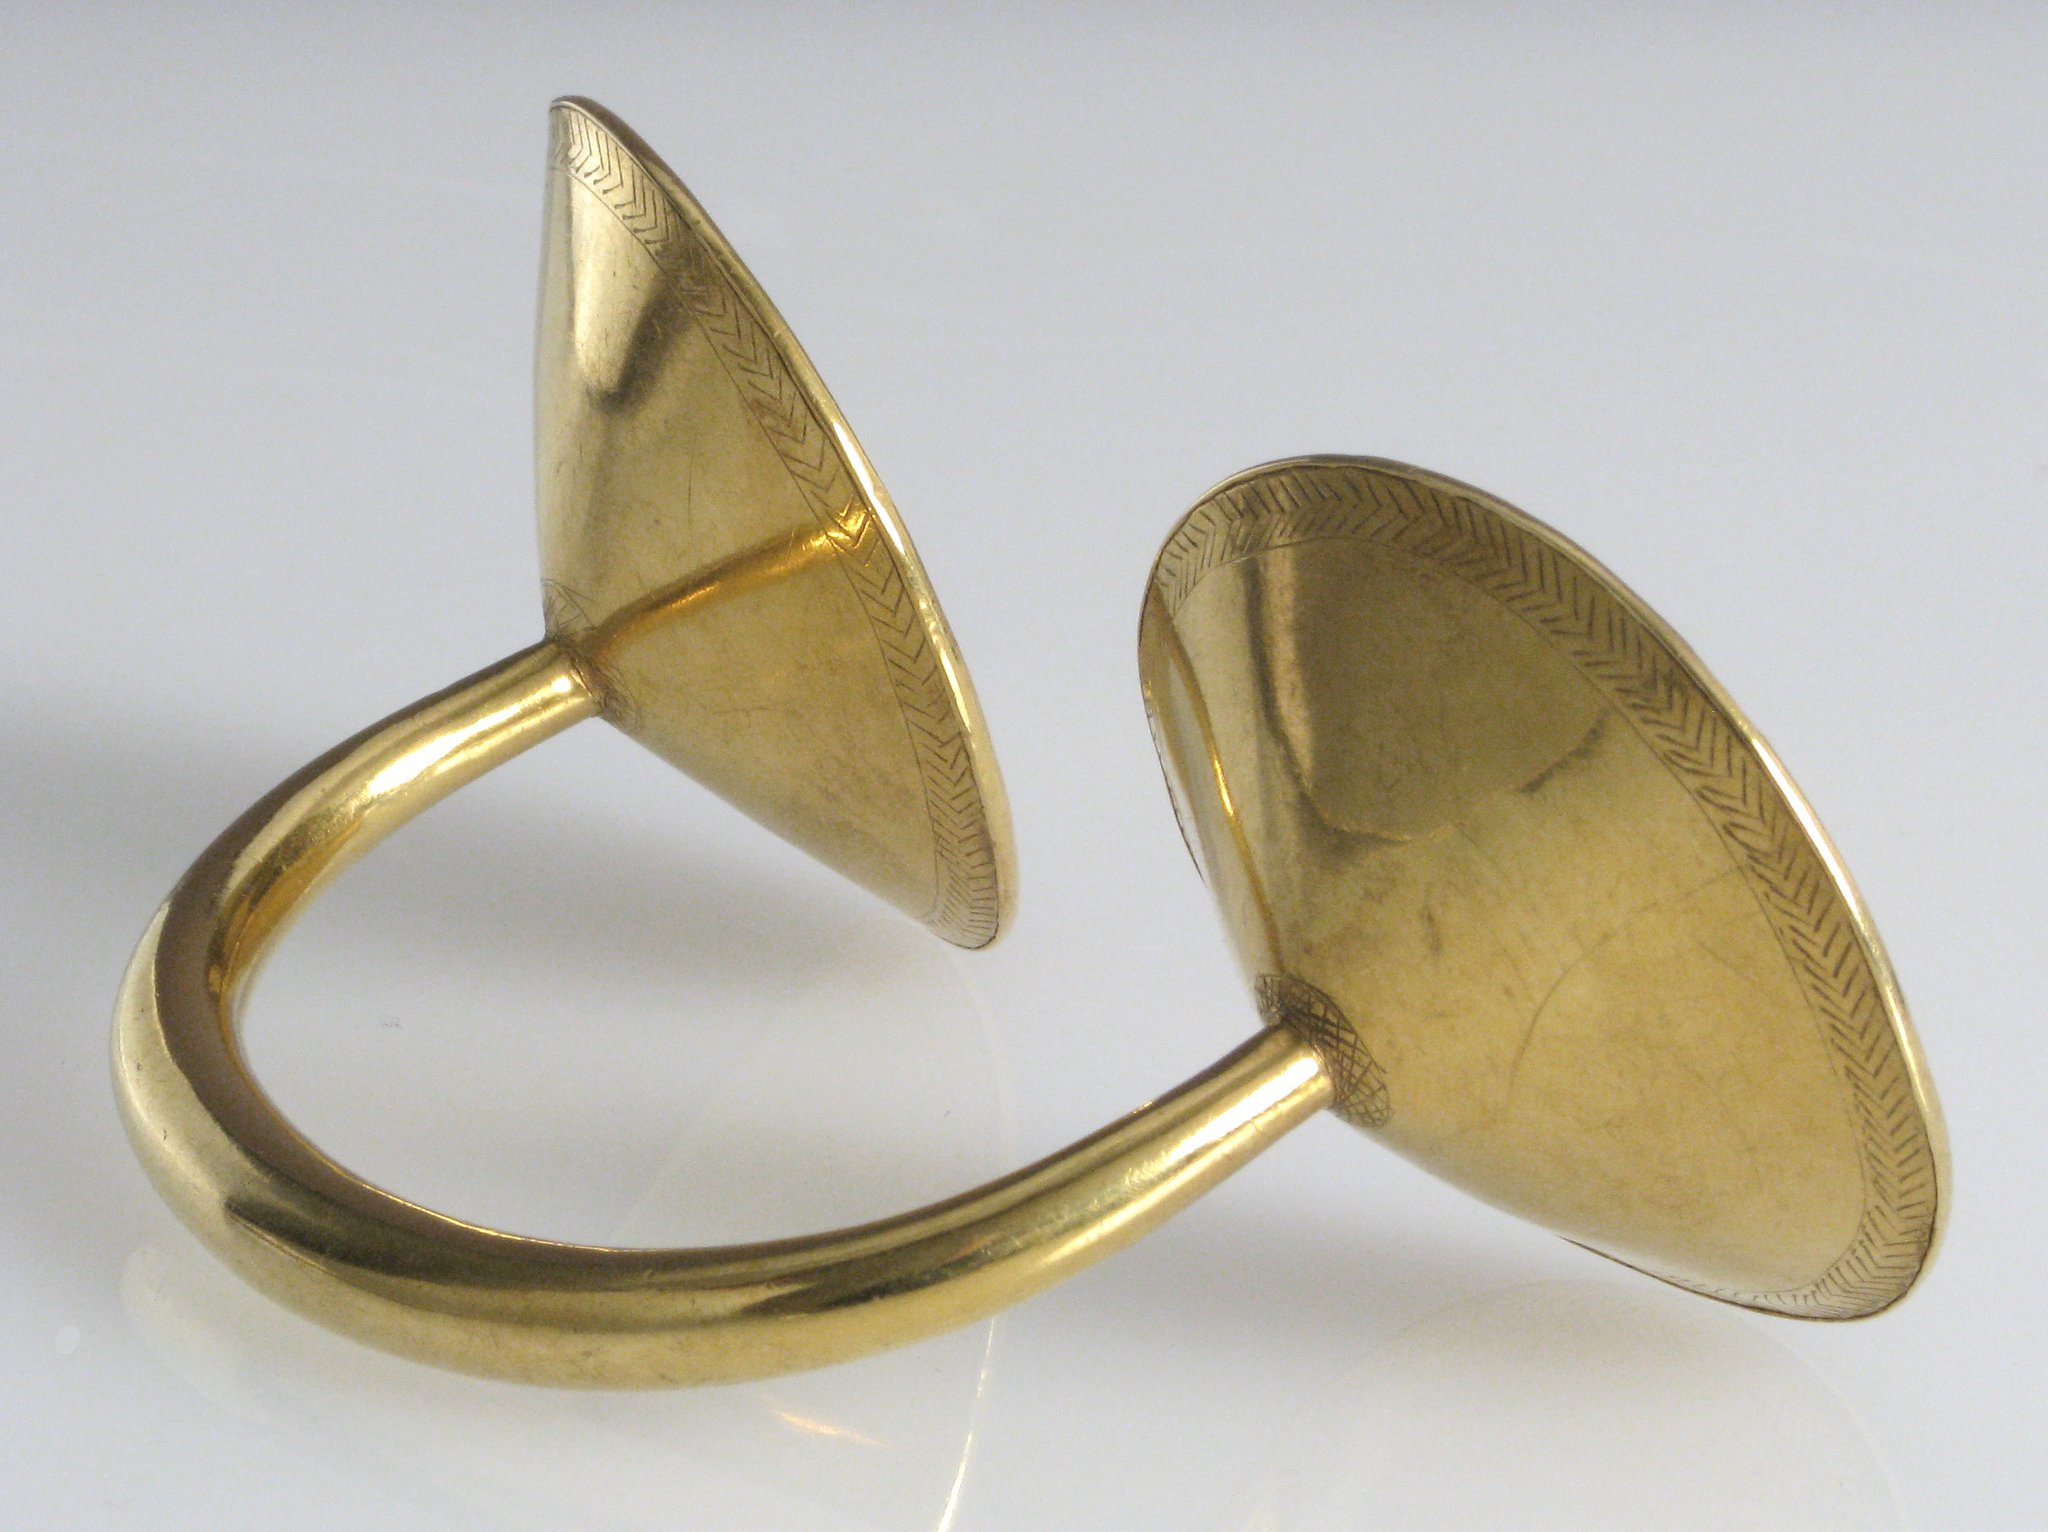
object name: ornament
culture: irish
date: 800 BCE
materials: gold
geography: ireland